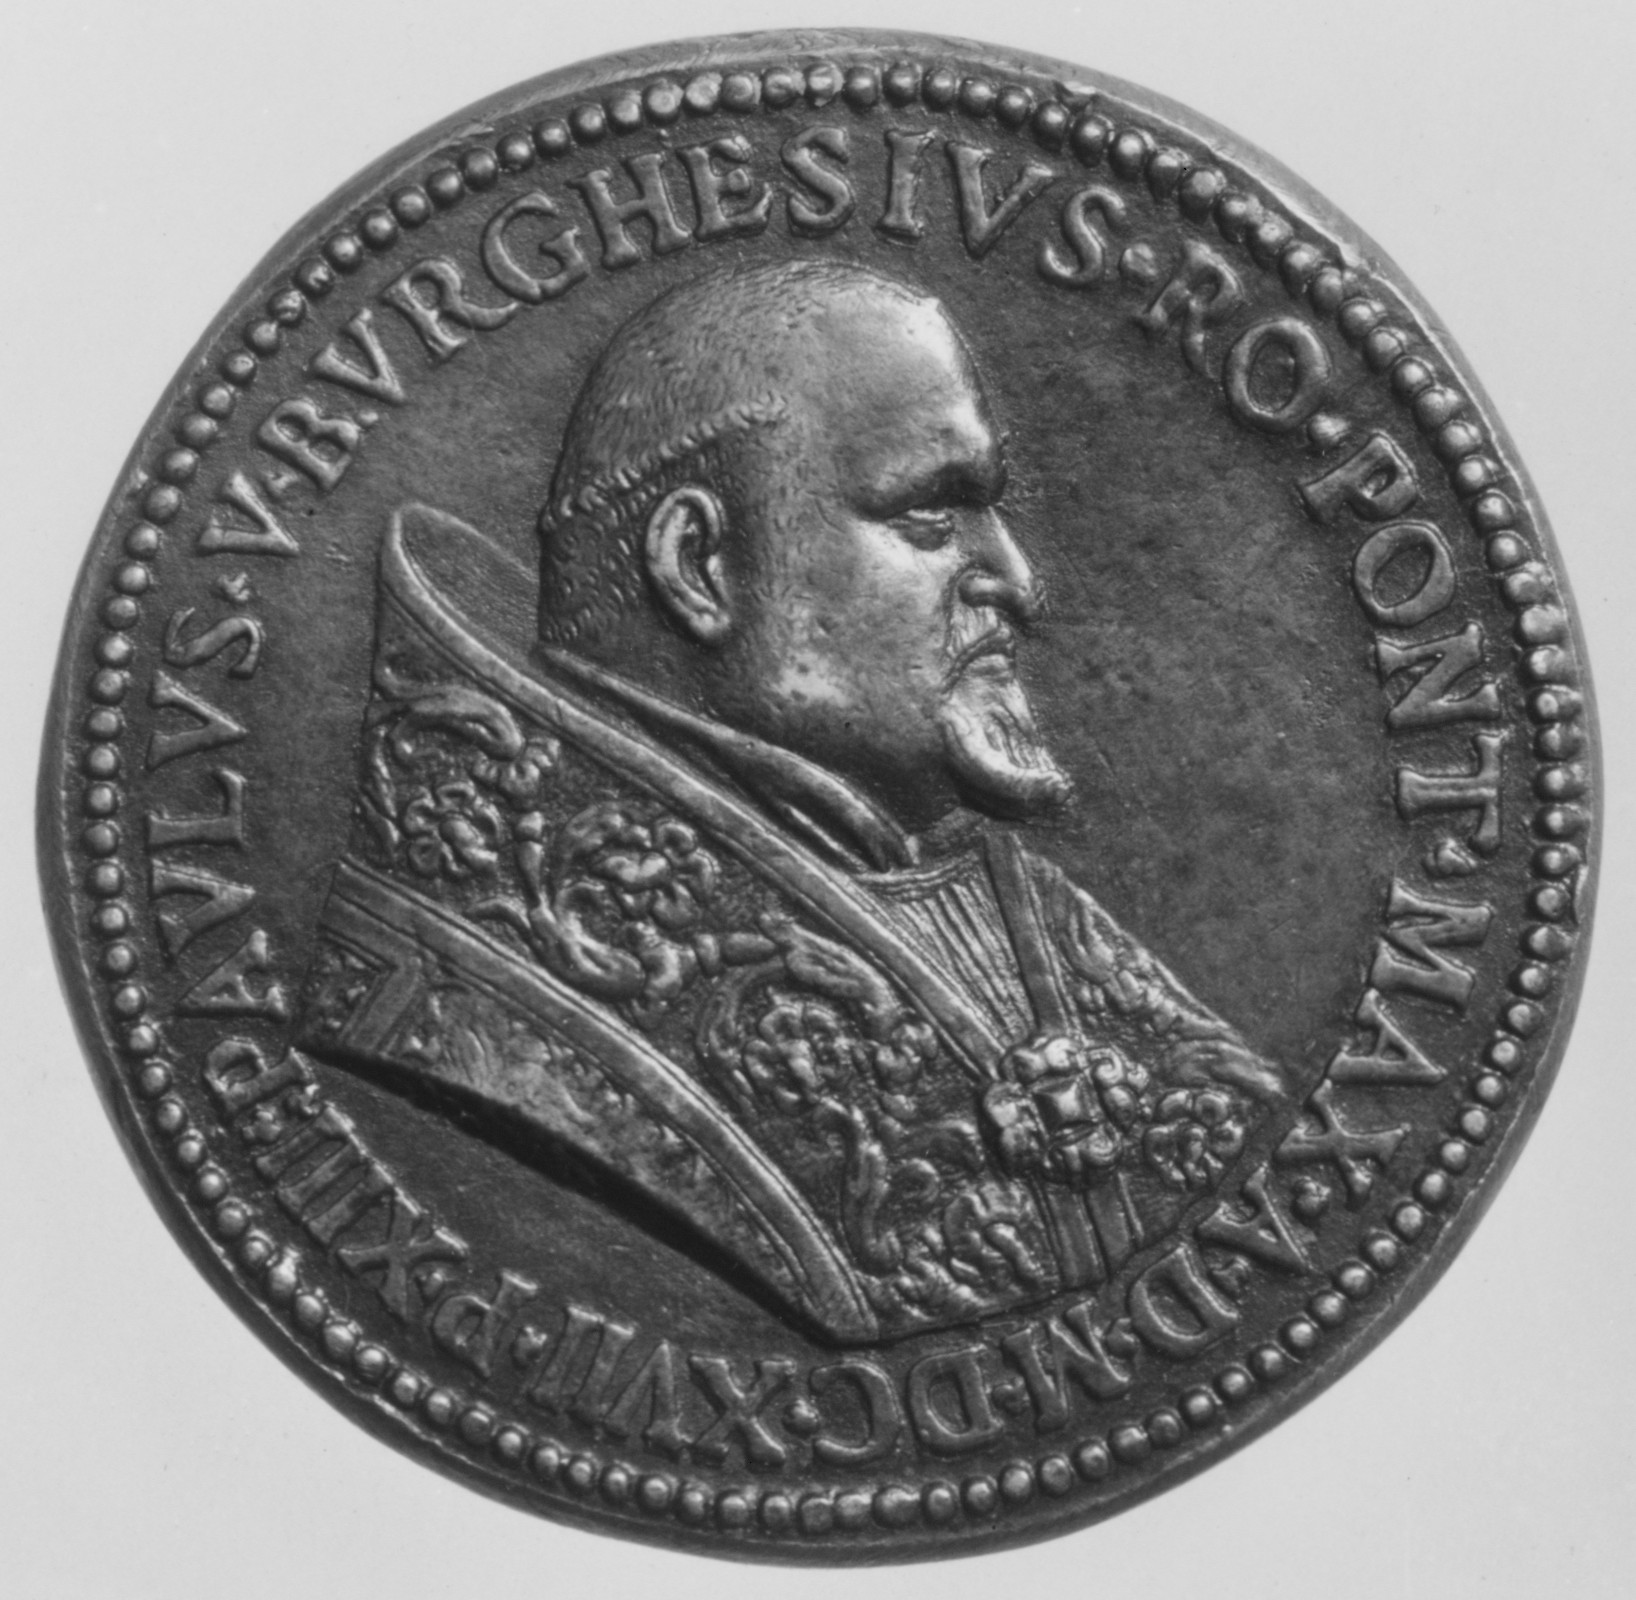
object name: medal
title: Pope Paul V (Camillo Borghese), 1552–1621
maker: giacomo antonio moro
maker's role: artist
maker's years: 1525-1625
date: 1617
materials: bronze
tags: men,profiles,popes